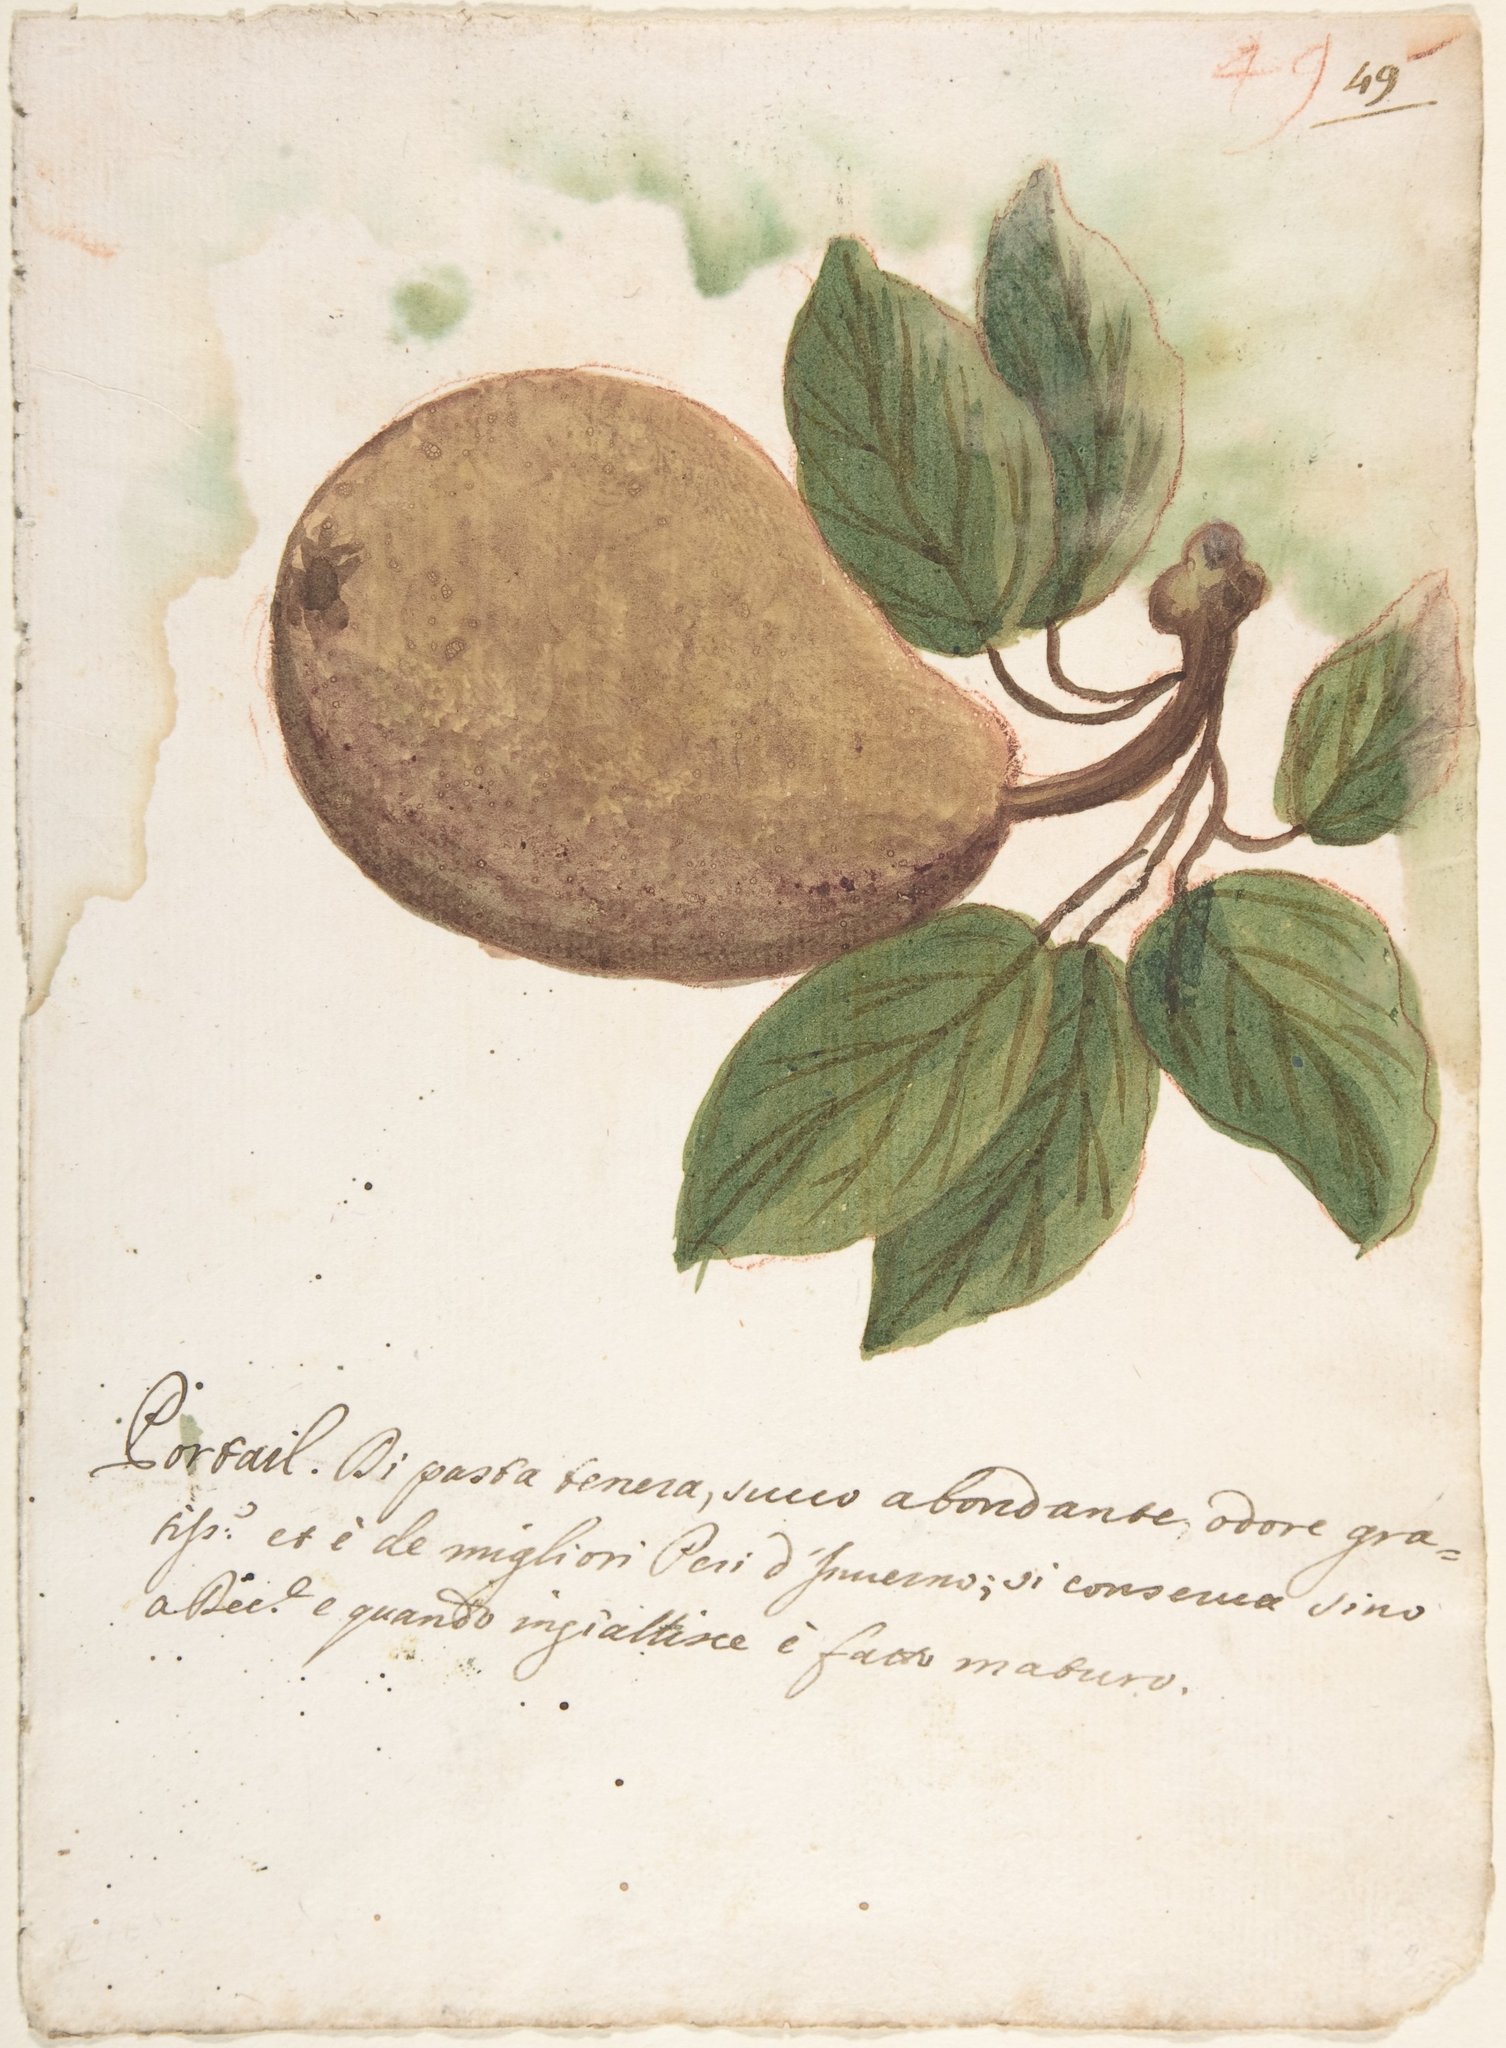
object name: drawing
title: Pear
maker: anonymous, italian, venetian, 18th century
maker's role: artist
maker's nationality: italian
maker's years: 1700-1800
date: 1701-1800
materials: chalk, crayon, paper, watercolor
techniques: brush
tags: pears,leaves